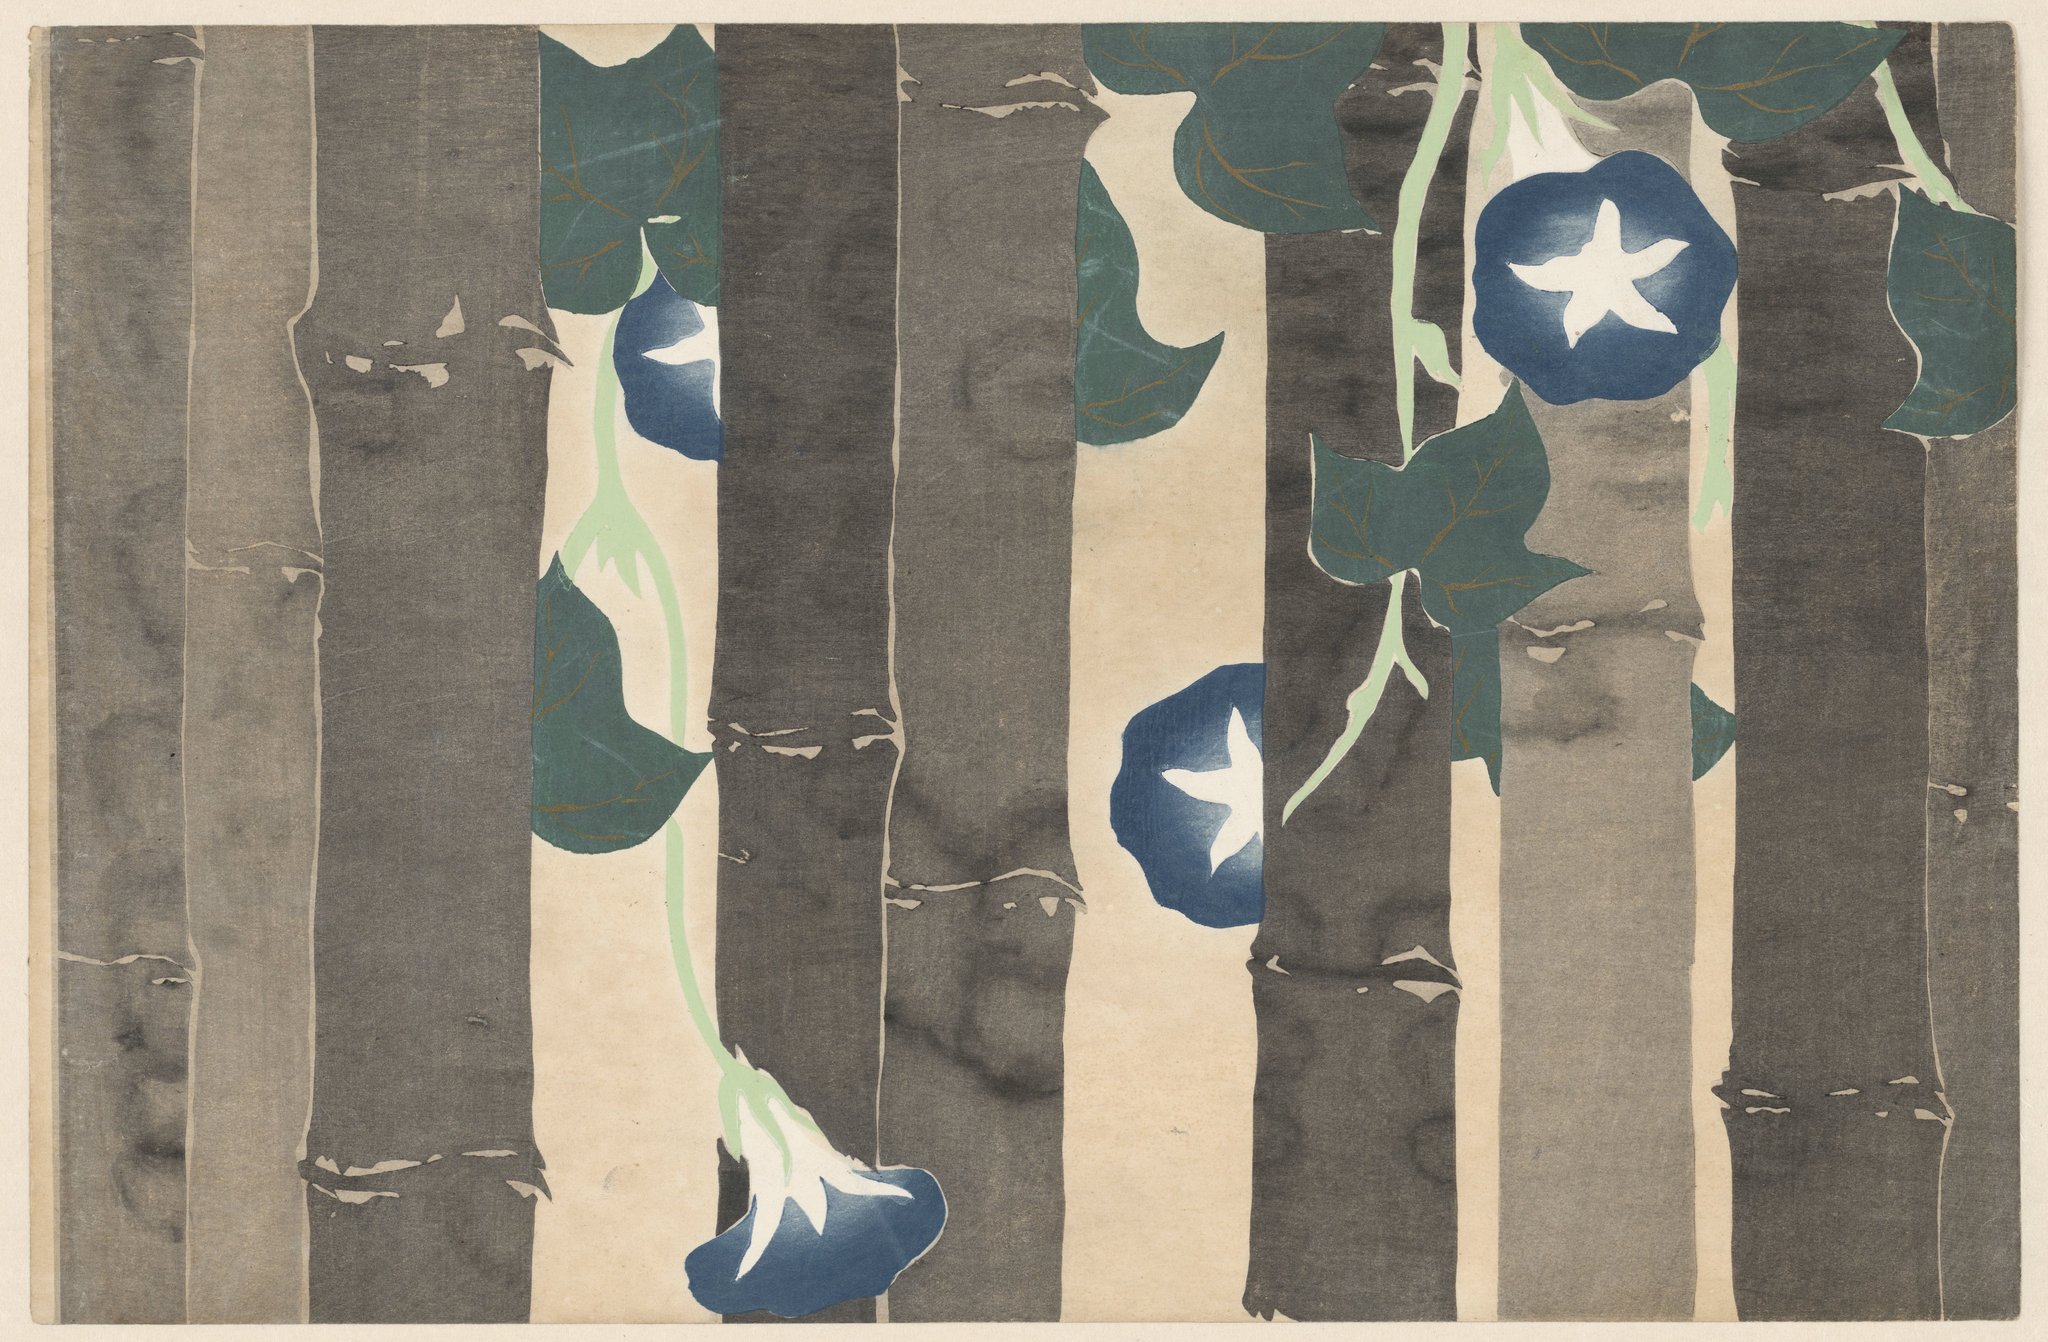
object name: print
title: Four Prints from the Series ‘Flowers of a Hundred Worlds’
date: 1909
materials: paper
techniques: woodcut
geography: kyoto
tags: flowers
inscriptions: collector's mark: Lugt 2760, collector's mark: Lugt 2228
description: The Rinpa School features stylized landscapes and motifs, with blocks of colour and in this instance without outlines. This style dates to the 17th century and was revived in a new form in the early 20th century. Sekka breathed new life into the movement. His designs profoundly influenced ceramics and lacquer in the 1900s to 1920s, especially in Kyoto.